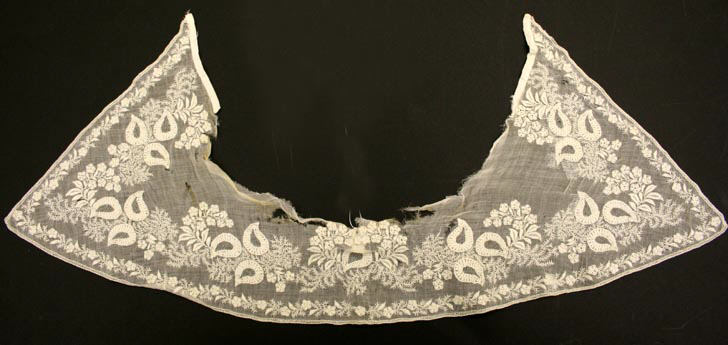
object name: collar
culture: american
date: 1840-1849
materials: cotton